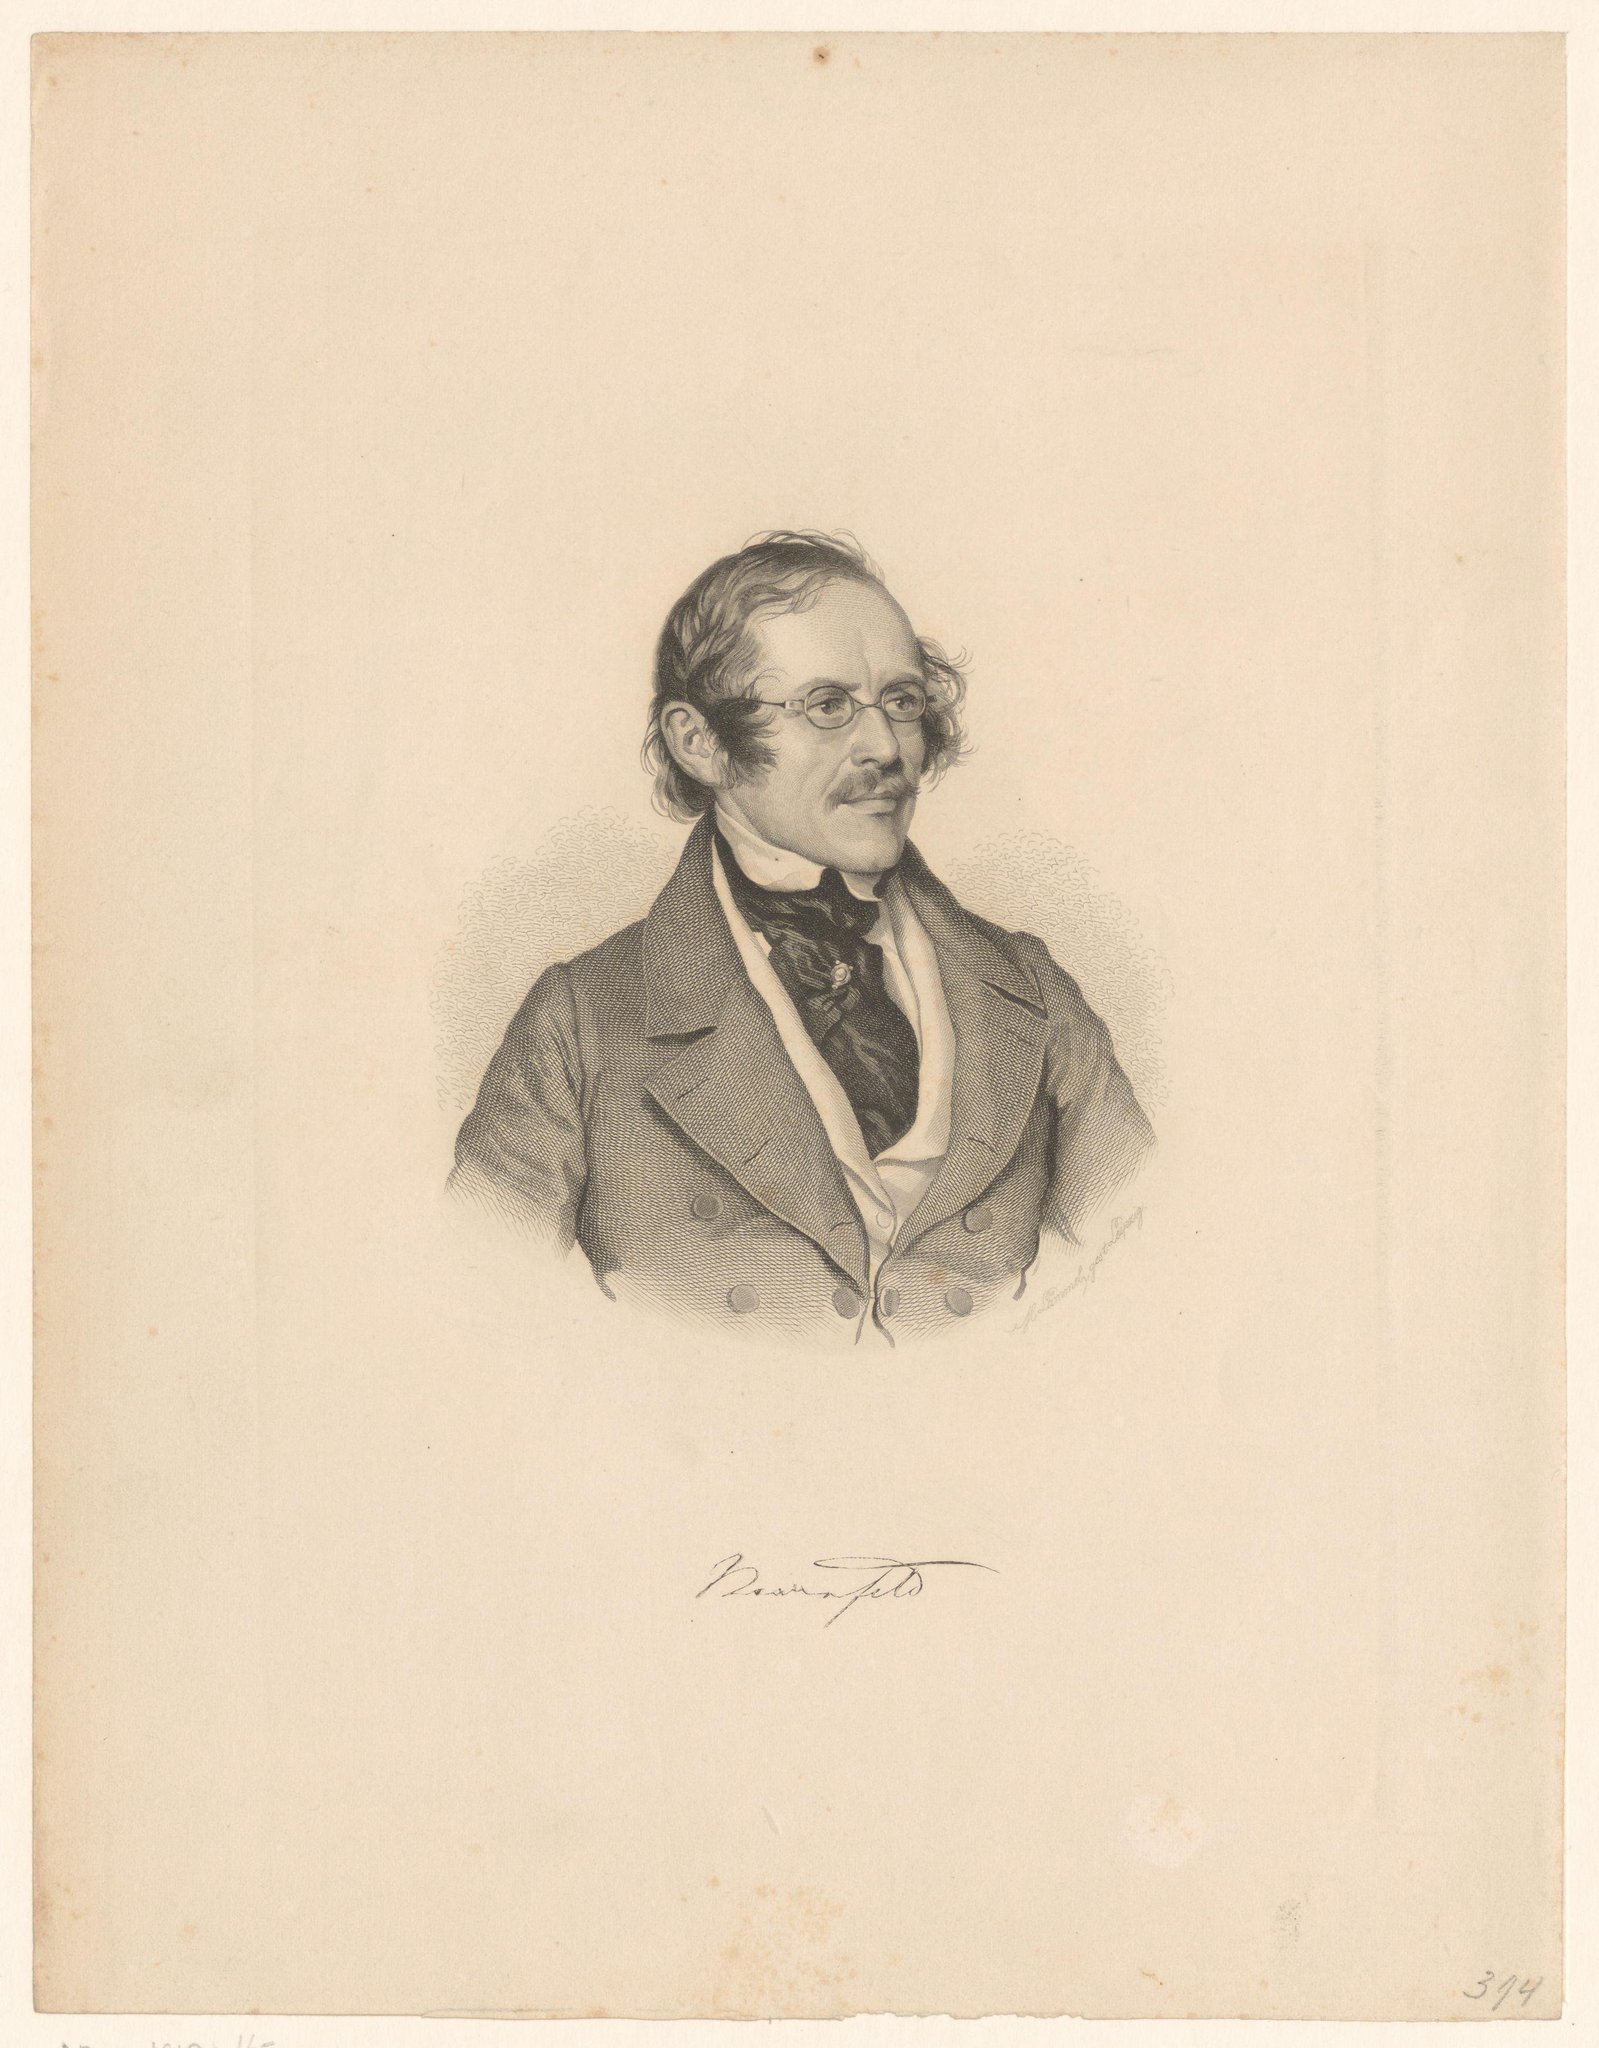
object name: print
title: Portret van Eduard von Bauernfeld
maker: moritz lämmel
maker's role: print maker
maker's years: 1822-1866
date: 1832-1866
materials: paper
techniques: engraving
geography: leipzig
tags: vienna, vienna state, historical persons, portrait of a writer, writer, poet, author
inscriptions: collector's mark: Lugt 2228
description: Een facsimile signatuur in de ondermarge.